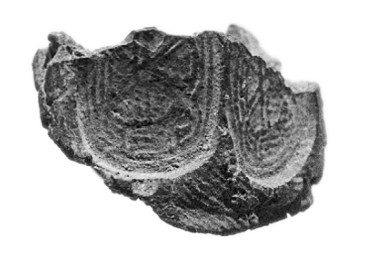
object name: sealing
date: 1981-1640 BCE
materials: clay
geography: egypt